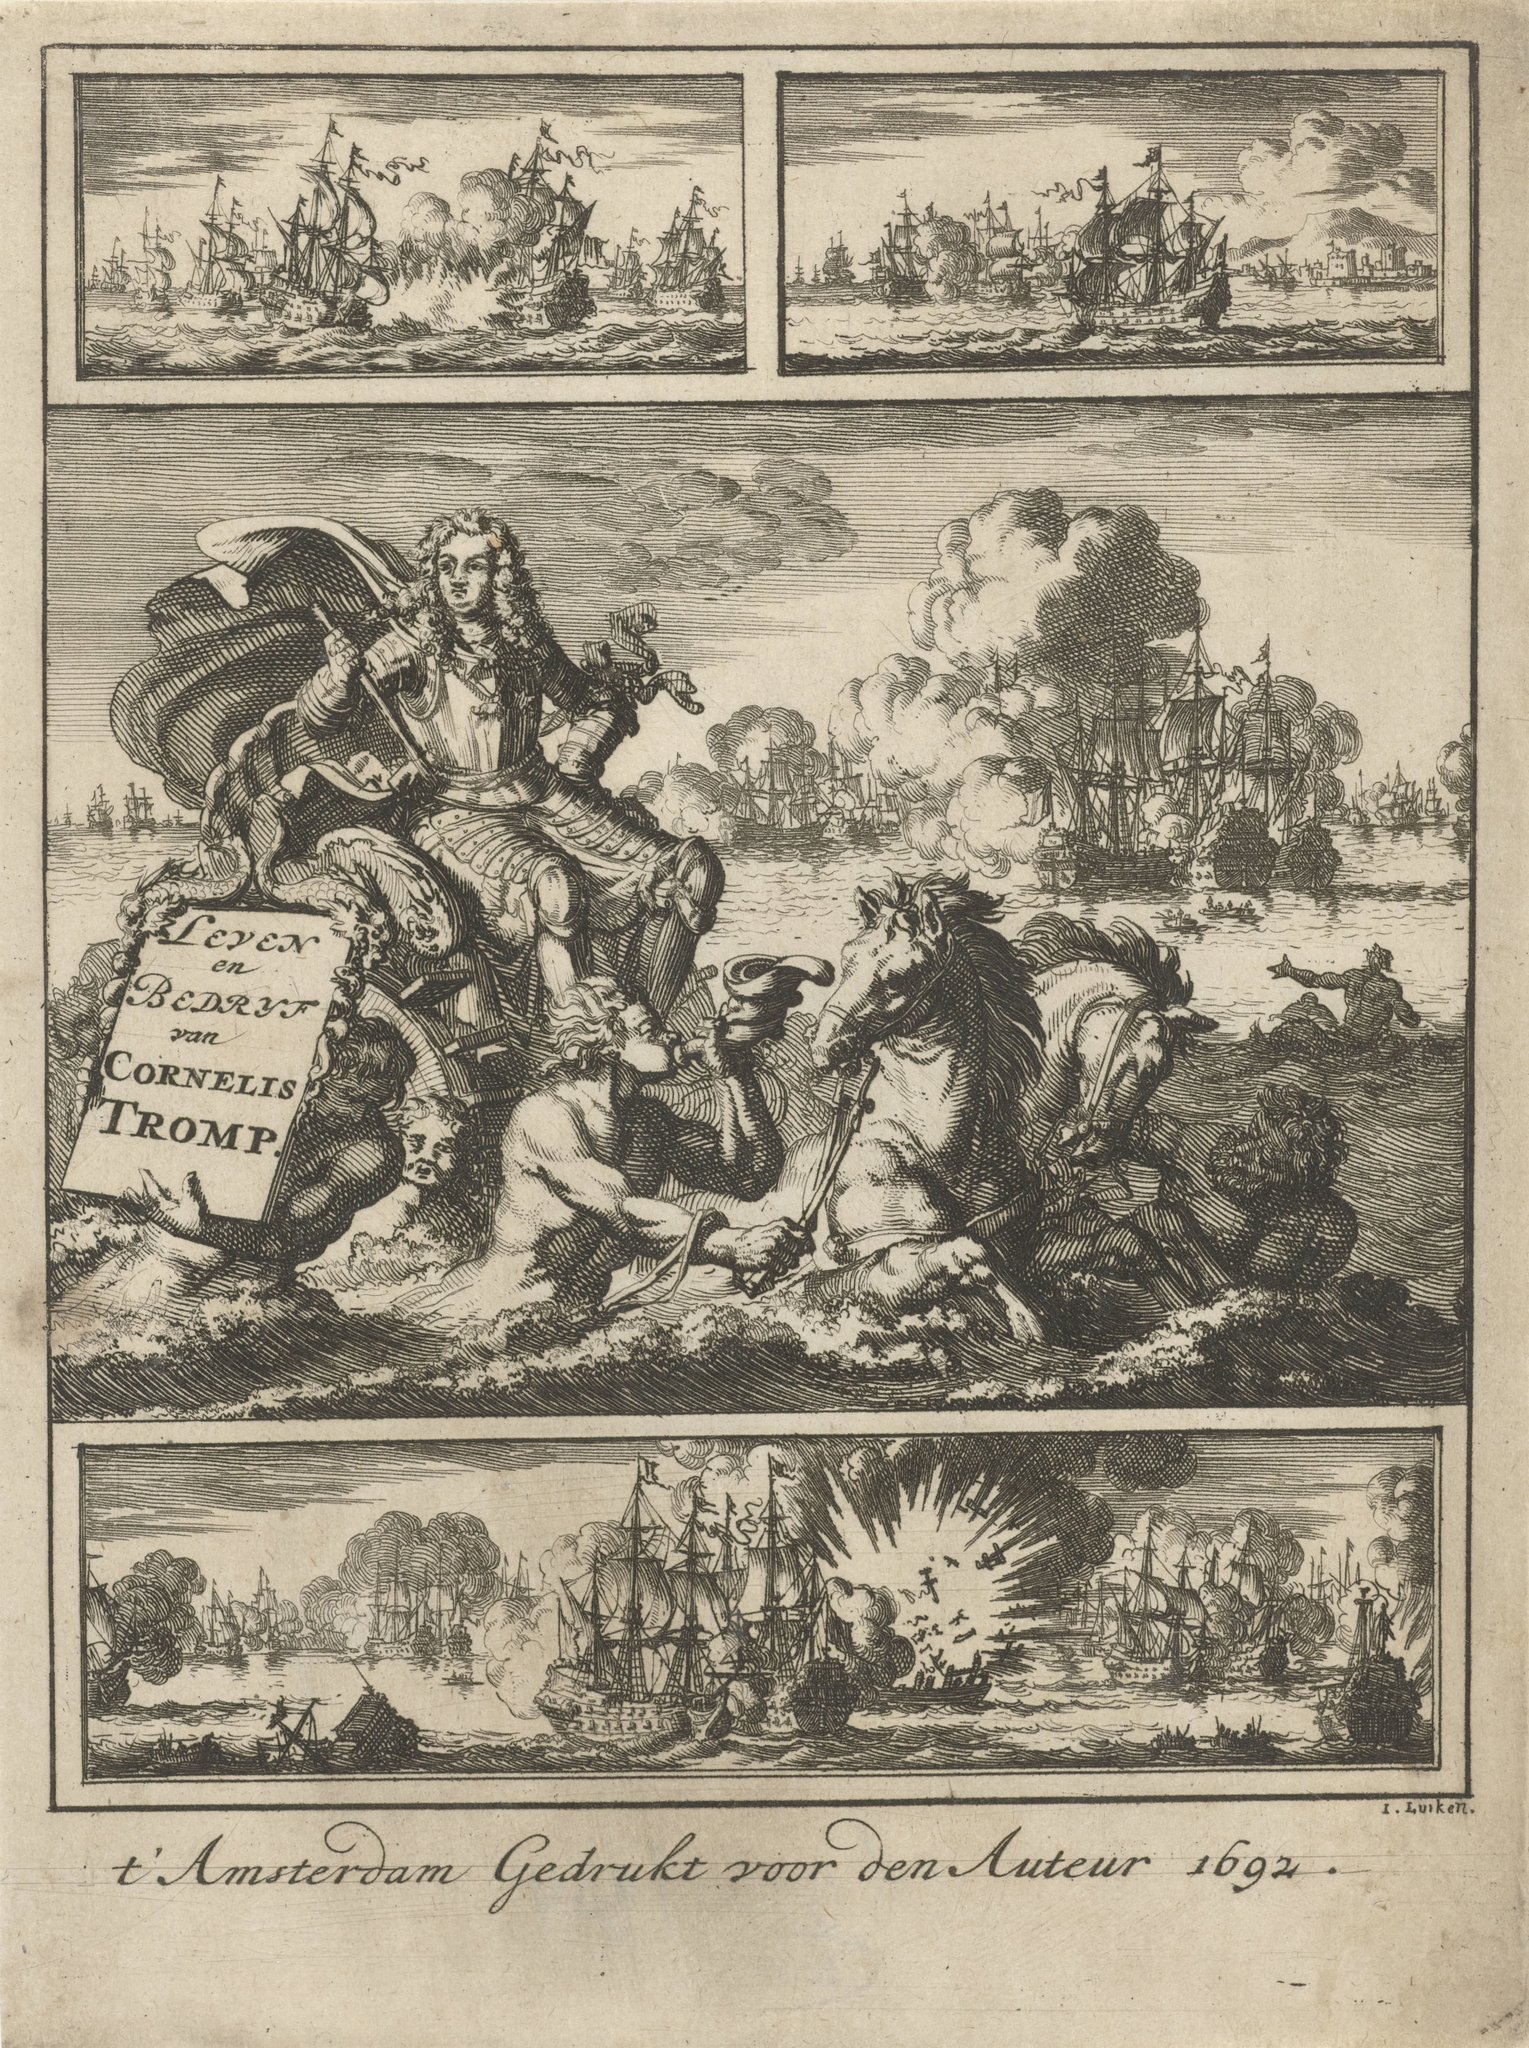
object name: print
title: Titelpagina voor: Leven en bedryf van den vermaarden zeeheld Cornelis Tromp, 1692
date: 1692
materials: paper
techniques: etching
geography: haarlem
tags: rotterdam, amsterdam, cornelis tromp, triton(s), sea-horse, hippocamp, 'hippocampus', (horse/fish) (mythological hybrid monster), commander-in-chief, admiral (+ naval force), chariot, triumphal car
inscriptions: collector's mark: Lugt 2228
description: Titelpagina voor: Leven en bedryf van den vermaarden zeeheld Cornelis Tromp. Amsterdam: Timotheus ten Hoorn; Haarlem: Jacob Albertsz van Beverwĳk, 1692.